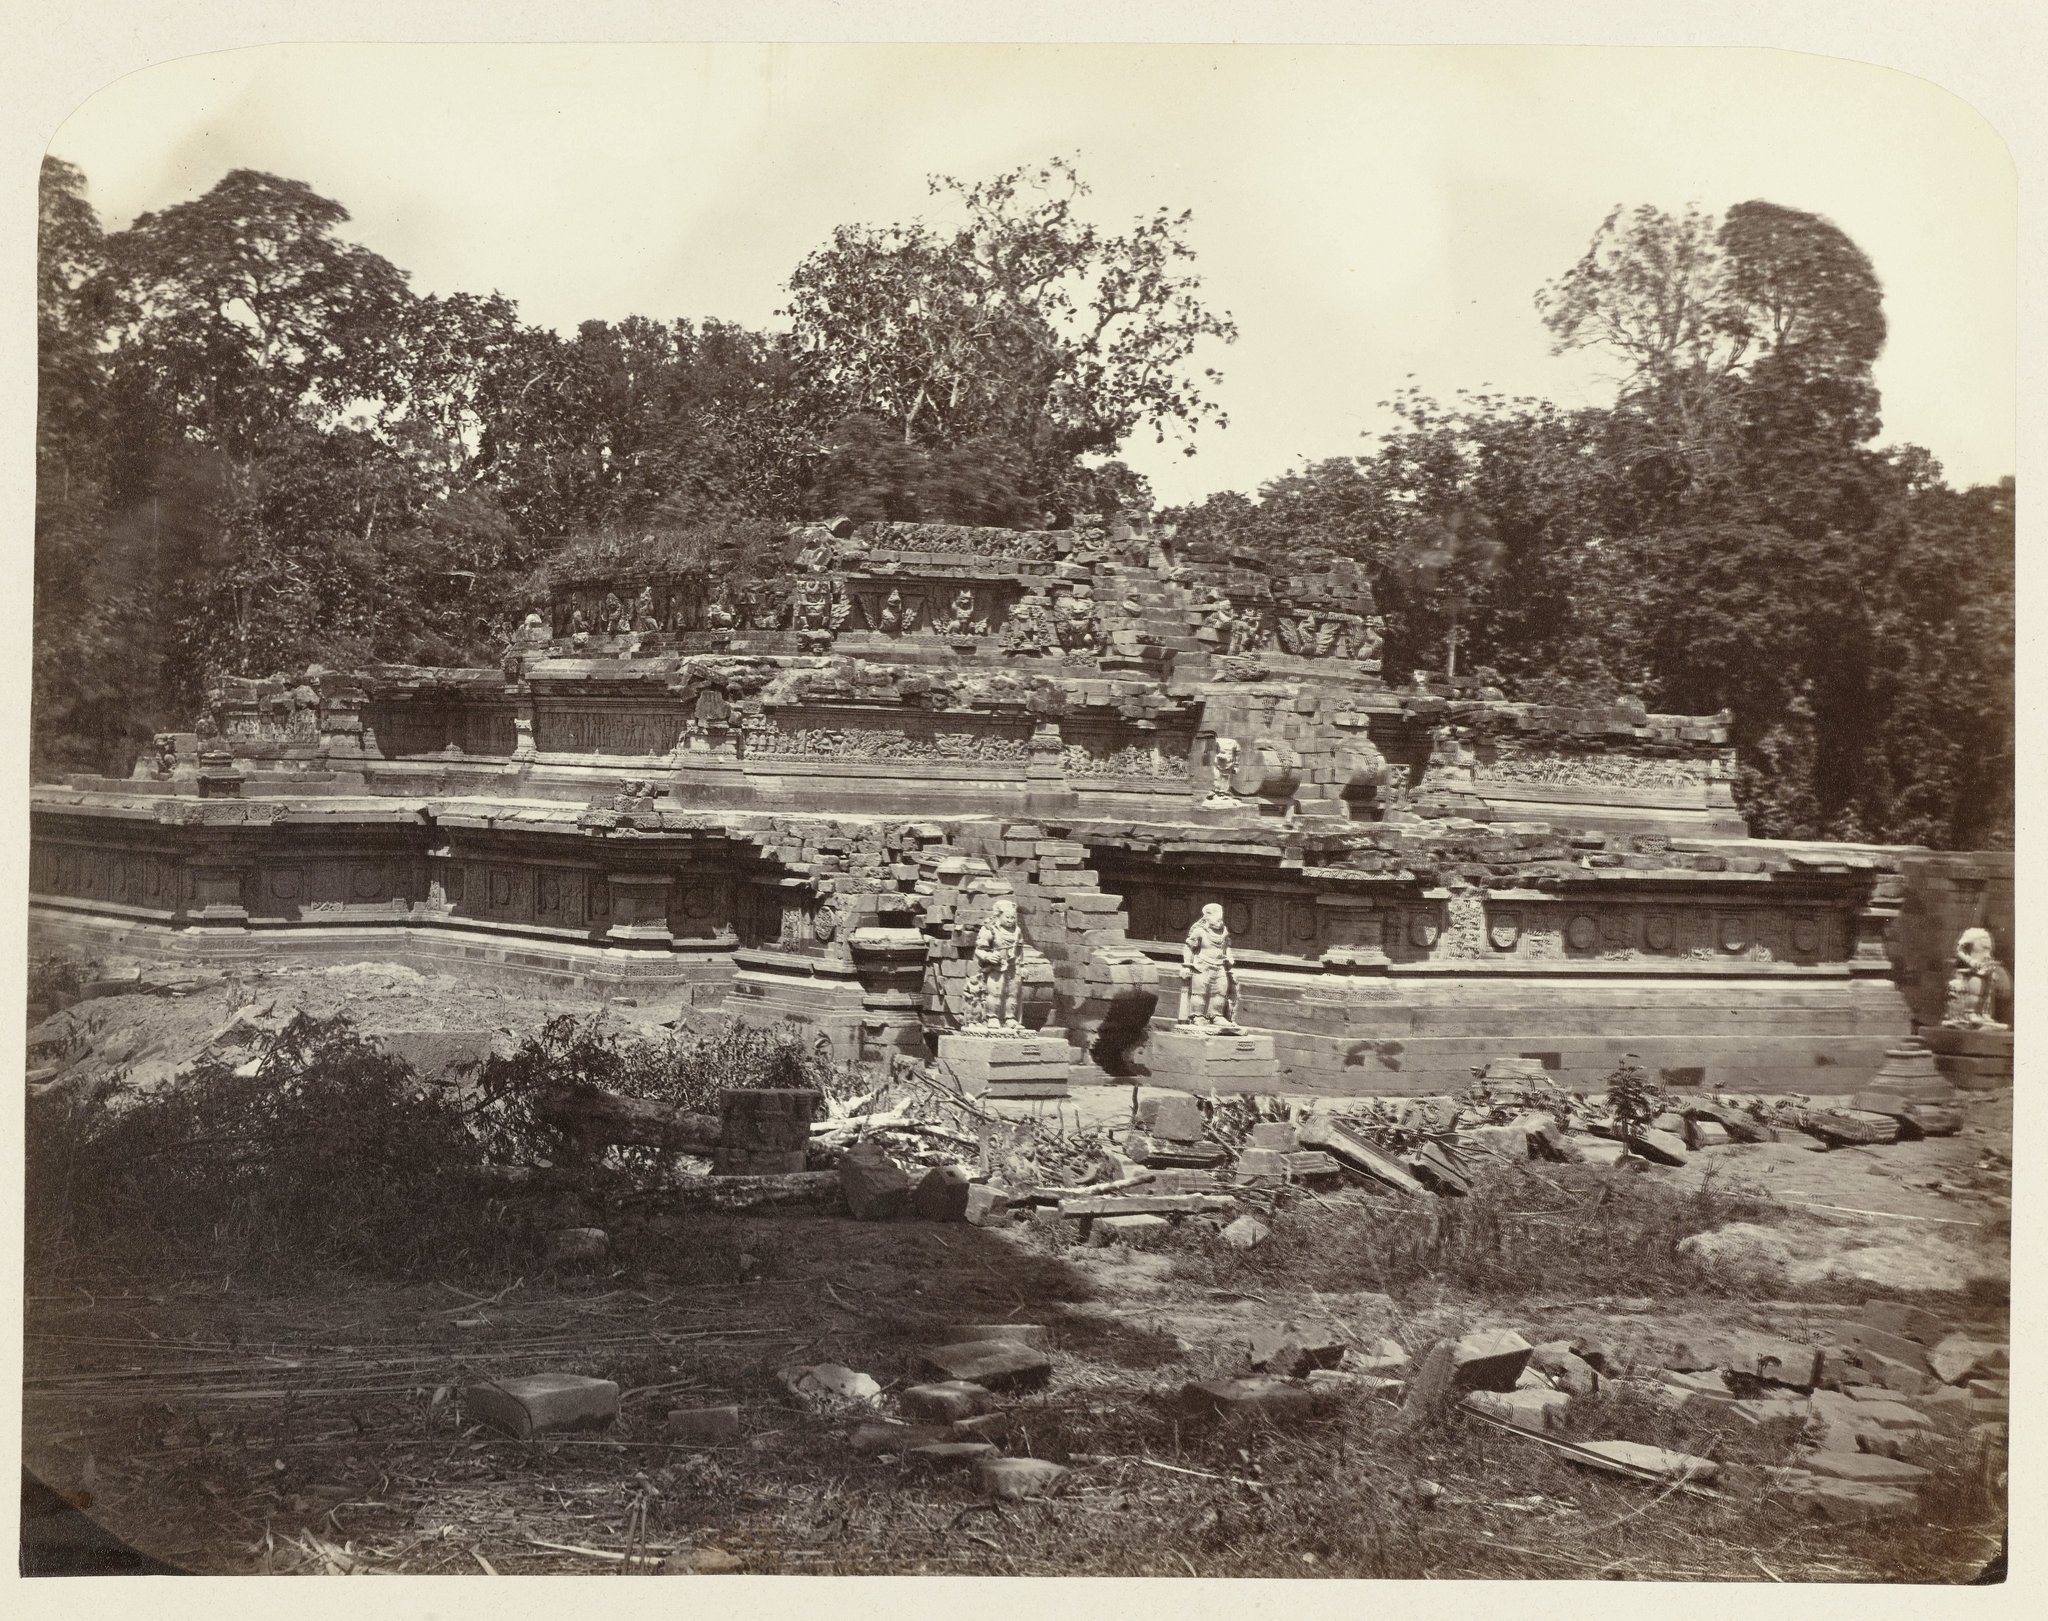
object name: photograph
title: Tempel, Panataran (r. Kediri)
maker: isidore kinsbergen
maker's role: fotograaf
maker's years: 1821-1905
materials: cardboard, paper, photographic support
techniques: albumen print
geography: java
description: Candi Panataran (Temple Complex), main Temple; general view of the facade (west) and northern side wall.